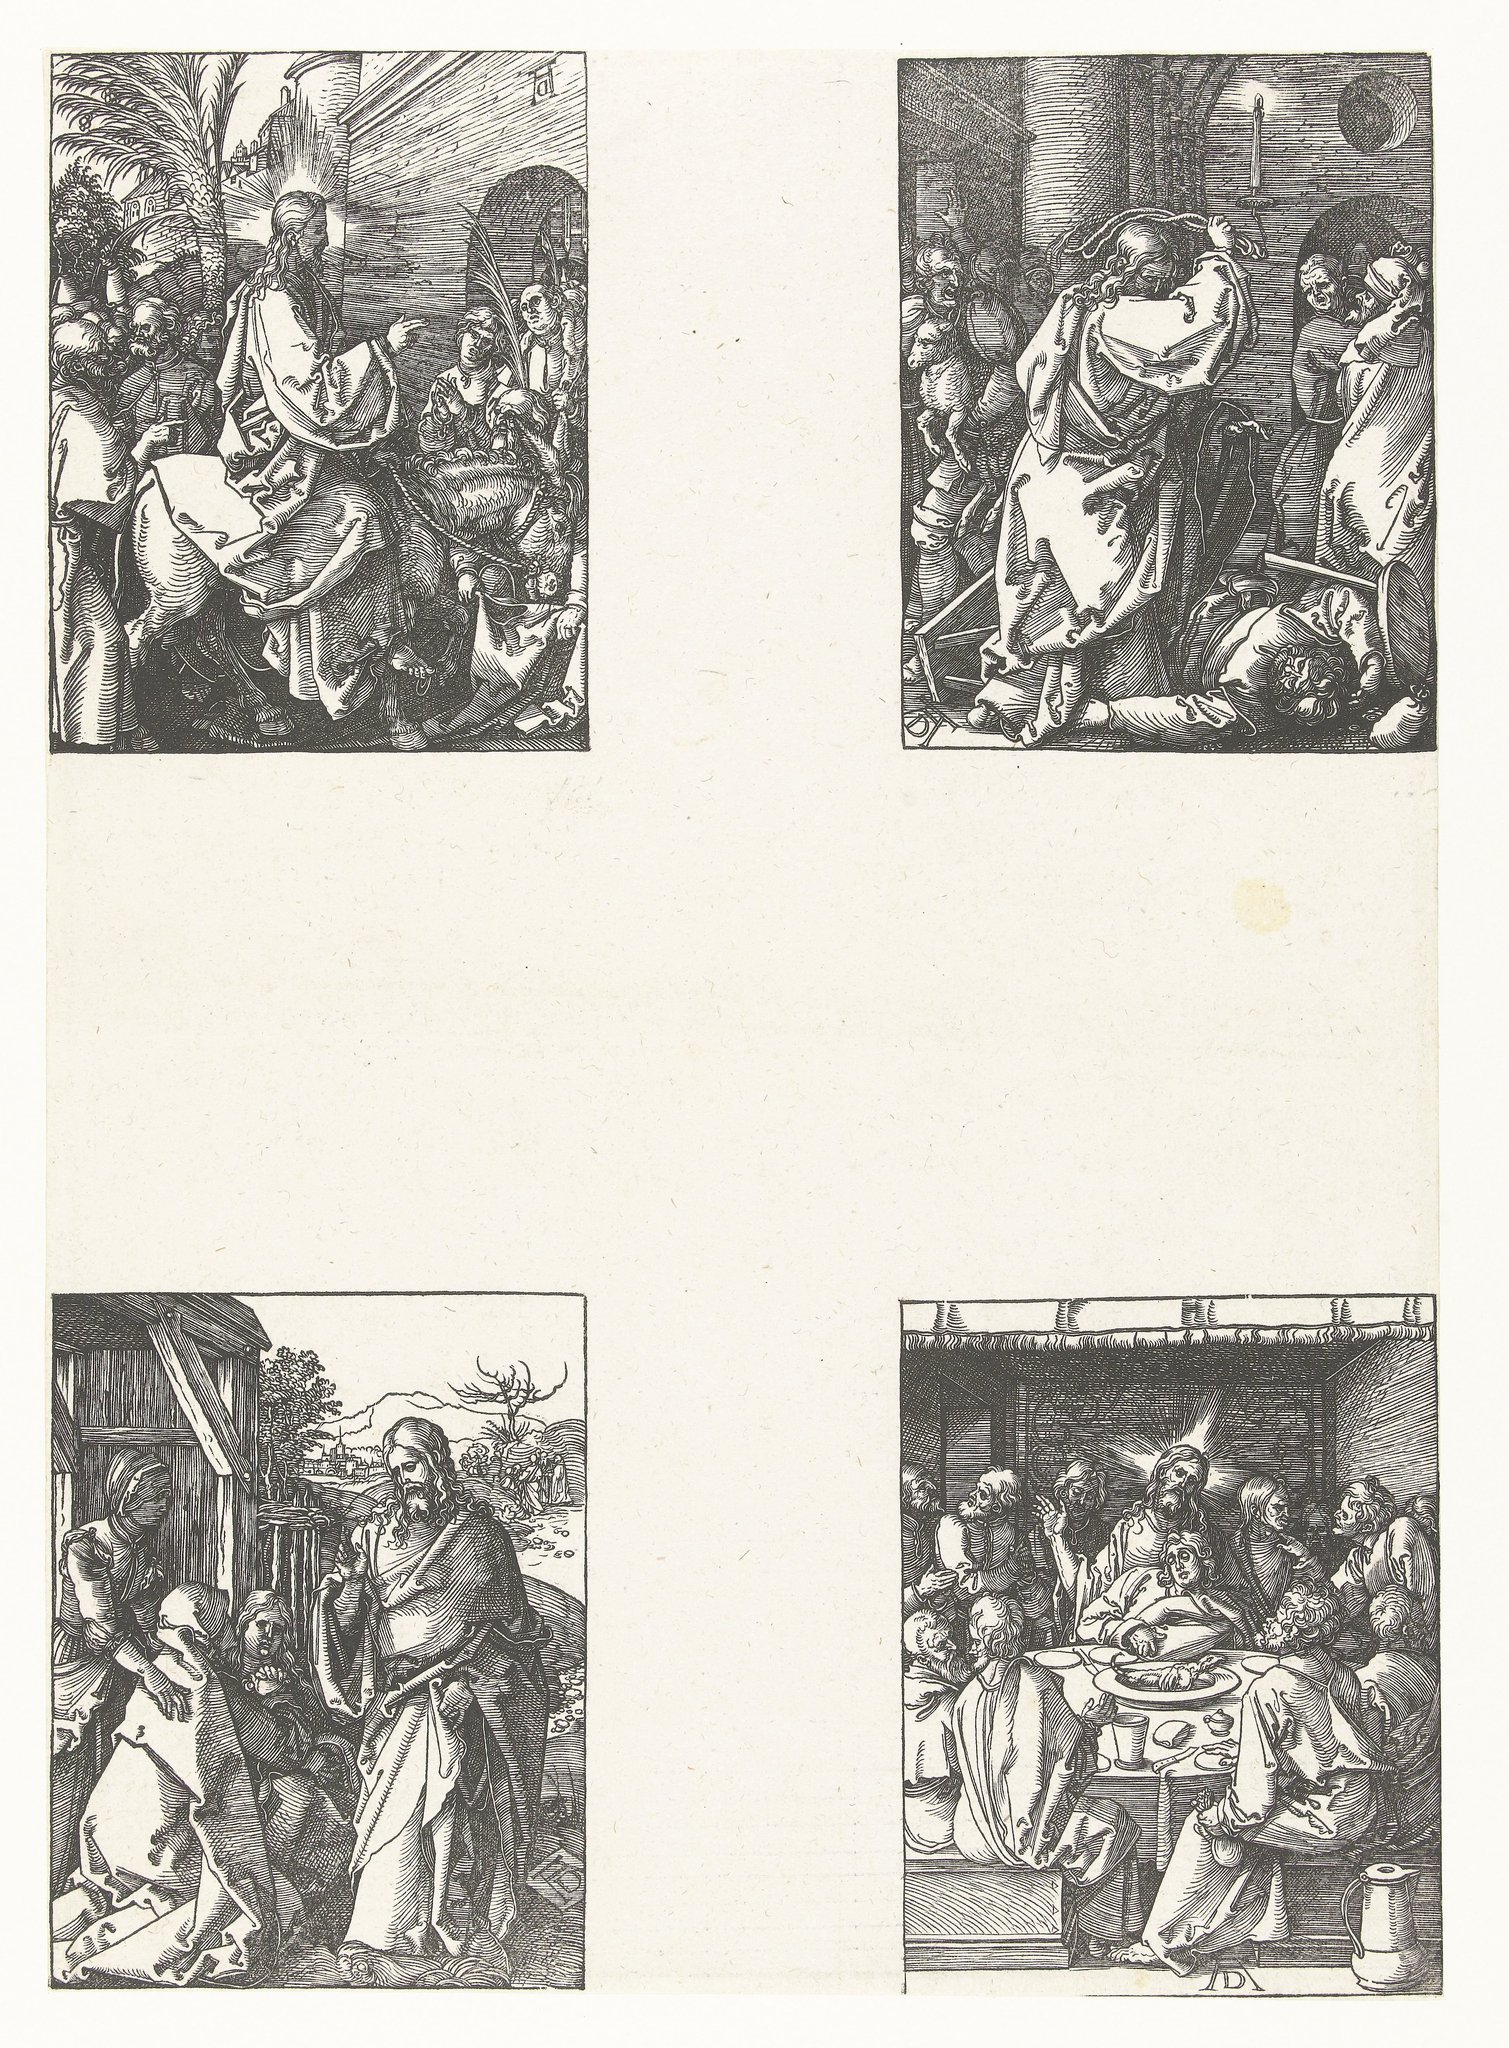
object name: print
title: De kleine Passie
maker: albrecht dürer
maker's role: draughtsman, painter, print maker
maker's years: 1471-1528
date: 1508-1509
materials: paper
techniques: woodcut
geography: nuremberg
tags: purification of the temple ('first' and 'second'): christ driving the money-changers from the temple with a whip (matthew 21:12-13; mark 11:15-17; luke 19:45-46; john 12:12-19), last supper (in general) (matthew 26:21-35; mark 14:18-31; luke 22:3, 22:15-23; john 13:21-38), christ taking leave of mary, usually mary magdalene present, entry into jerusalem: people spreading their clothes before christ on the ass, and waving palm branches (matthew 21:1-11, 21:14-16; mark 11:1-11; luke 19:28-40; john 12:12-19)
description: De tweede reeks van vier scènes uit de prentserie 'De kleine Passie', hier nog onversneden met 4 afbeeldingen op 1 blad. Linksboven: Christus rijdt op een ezeltje Jeruzalem binnen. Rechtsboven: Christus verdrijft met een zweep de geldwisselaars uit de tempel. Linksonder: Christus neemt afscheid van zijn moeder, die geknield voor hem zit, met twee andere vrouwen om haar heen. Rechtsonder: Johannes vleit zich aan de borst van Christus tijdens het Laatste Avondmaal.